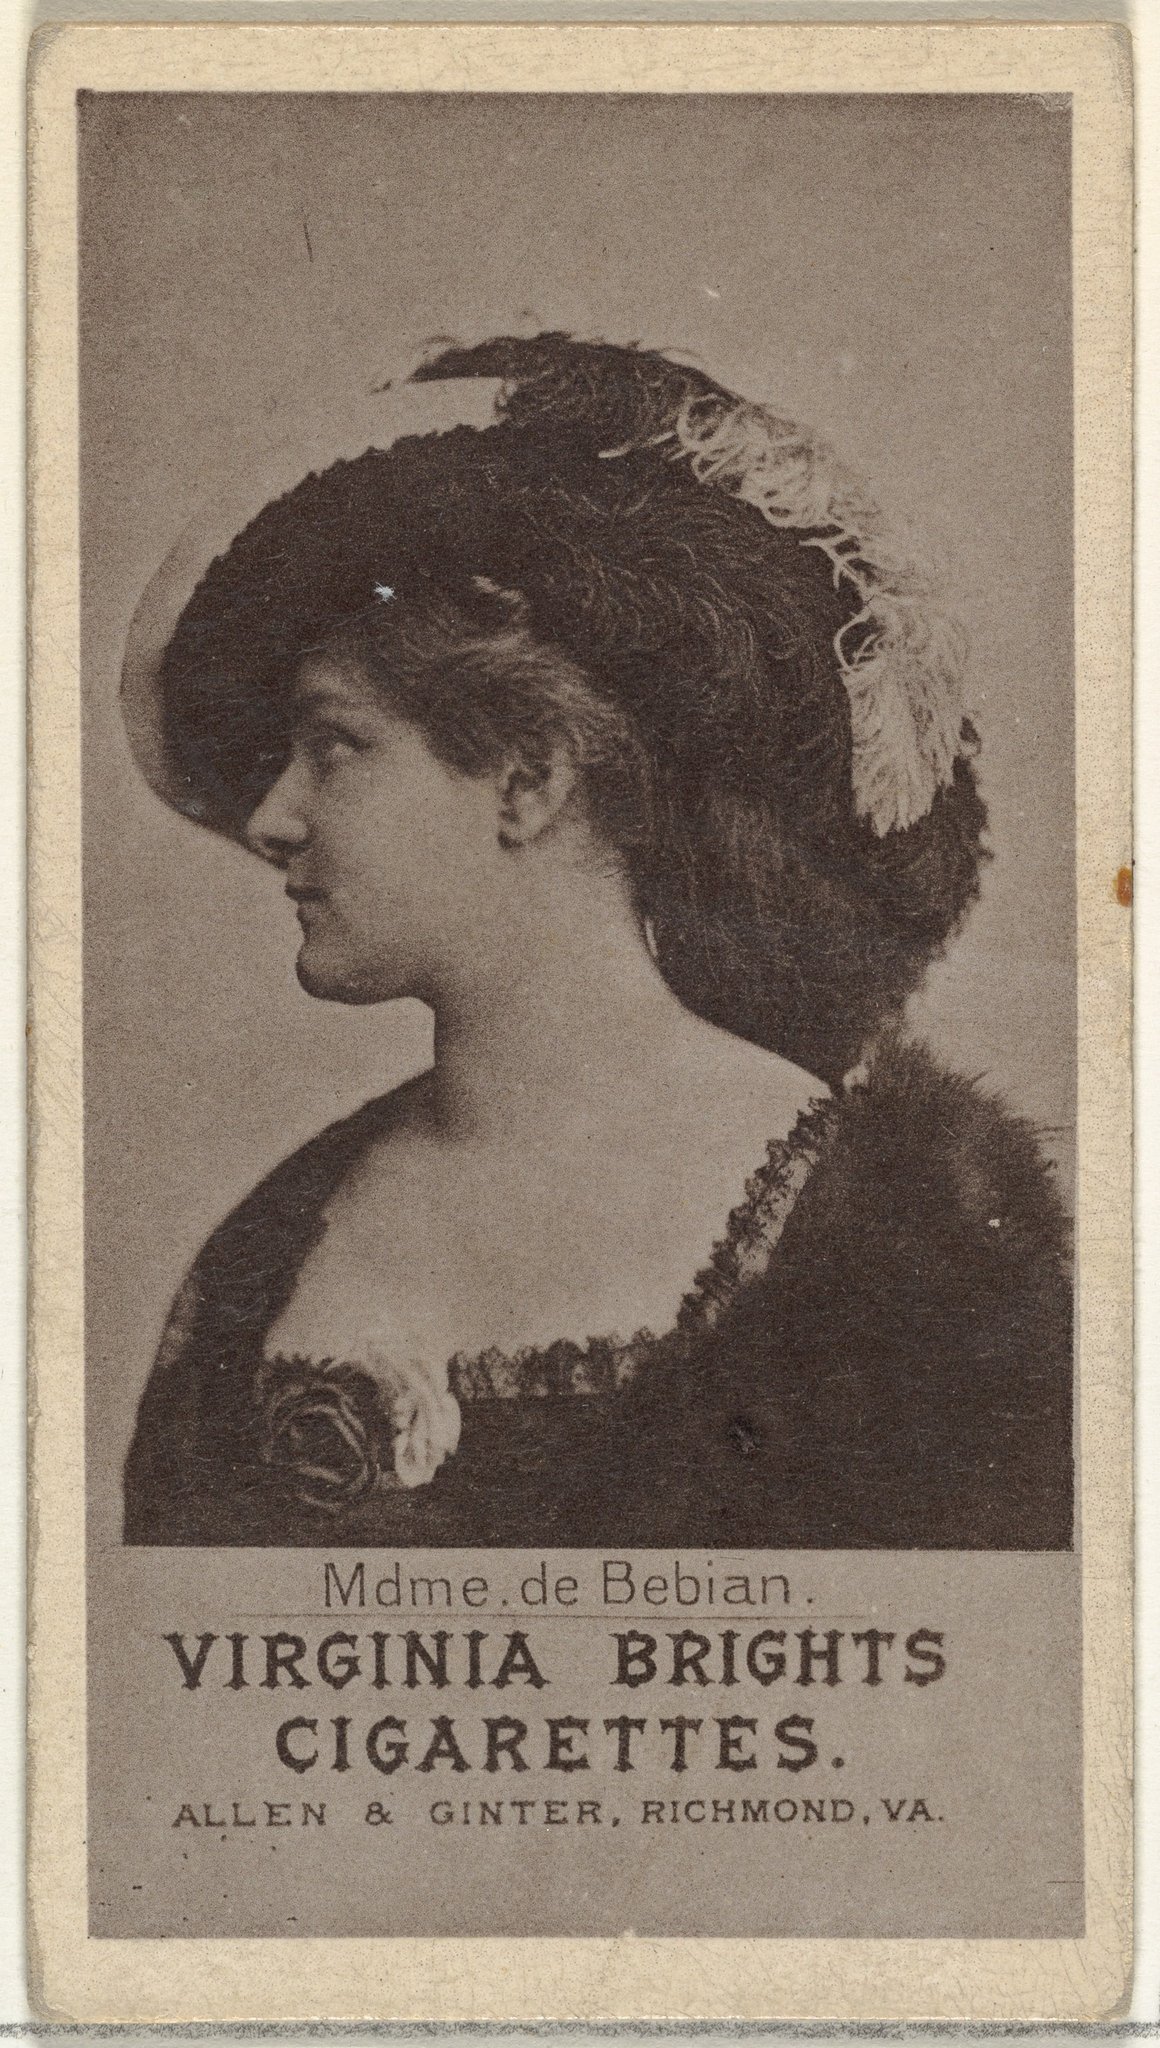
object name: print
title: Mdme. de Bebian, from the Actresses series (N67) promoting Virginia Brights Cigarettes for Allen & Ginter brand tobacco products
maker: allen & ginter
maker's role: publisher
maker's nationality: american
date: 1888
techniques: photolithograph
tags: portraits,women,actresses